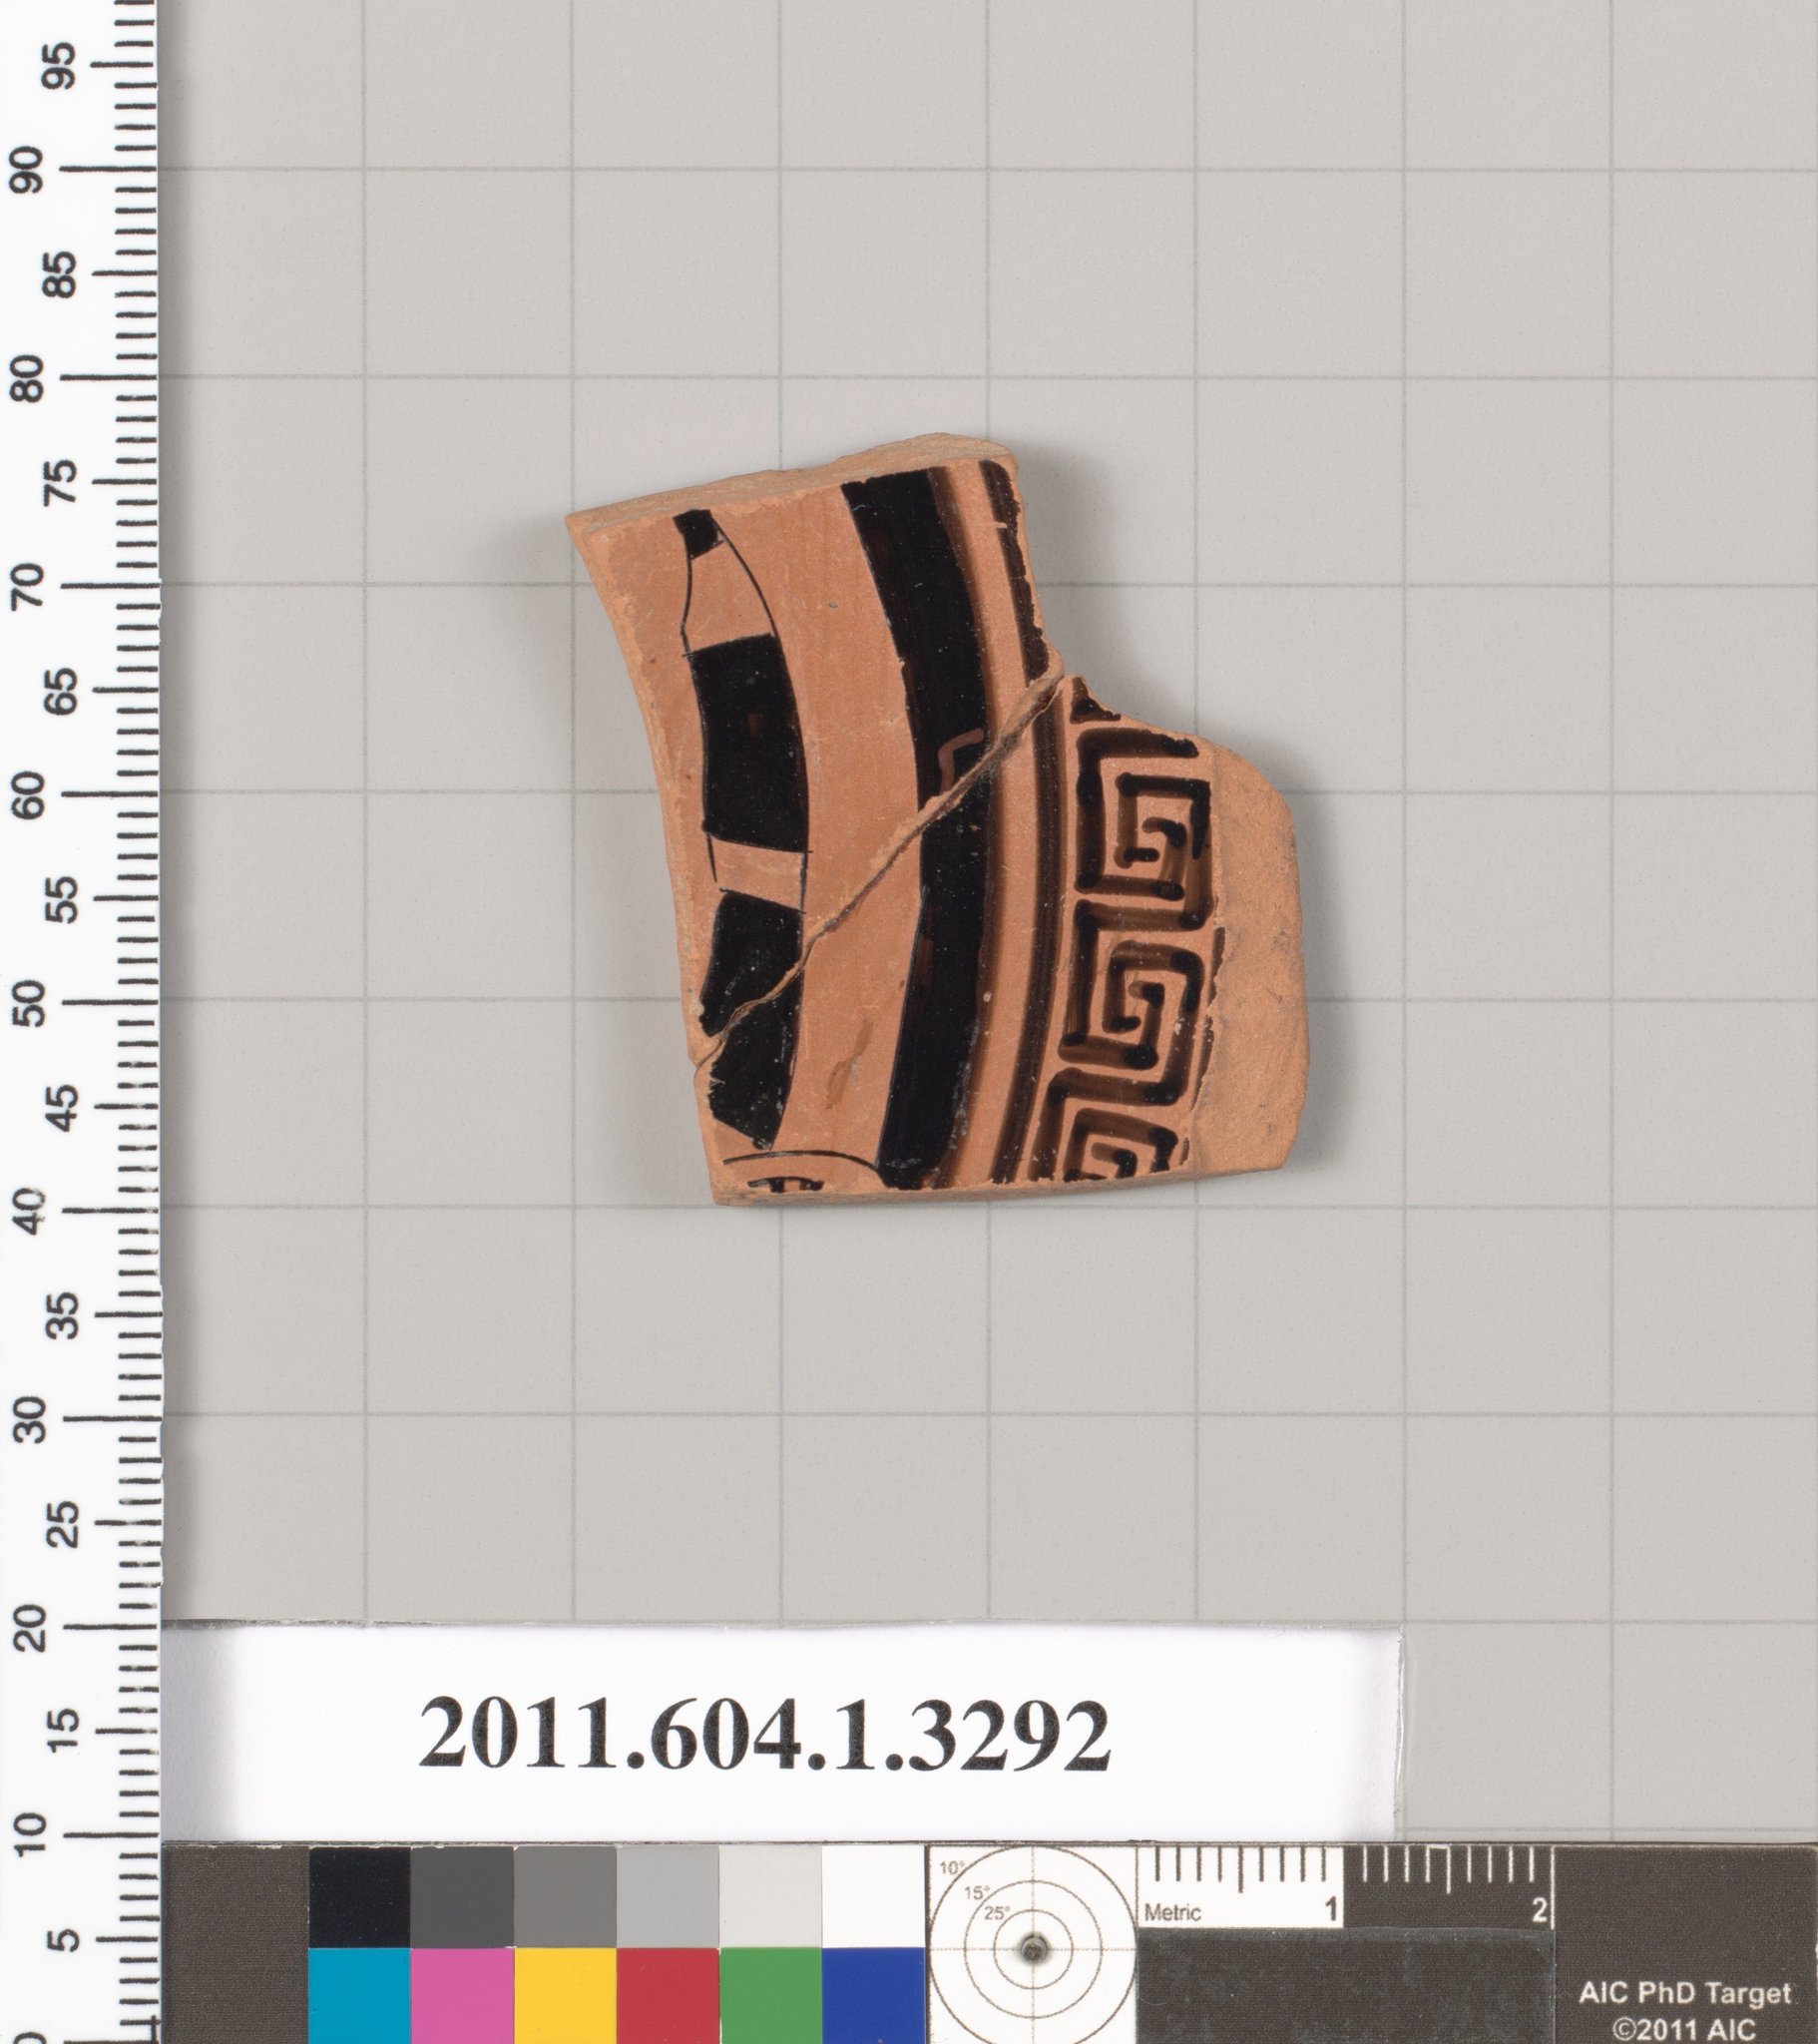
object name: kylix fragment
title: Terracotta fragment of a kylix (drinking cup)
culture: greek, attic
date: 490-480 BCE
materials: terracotta